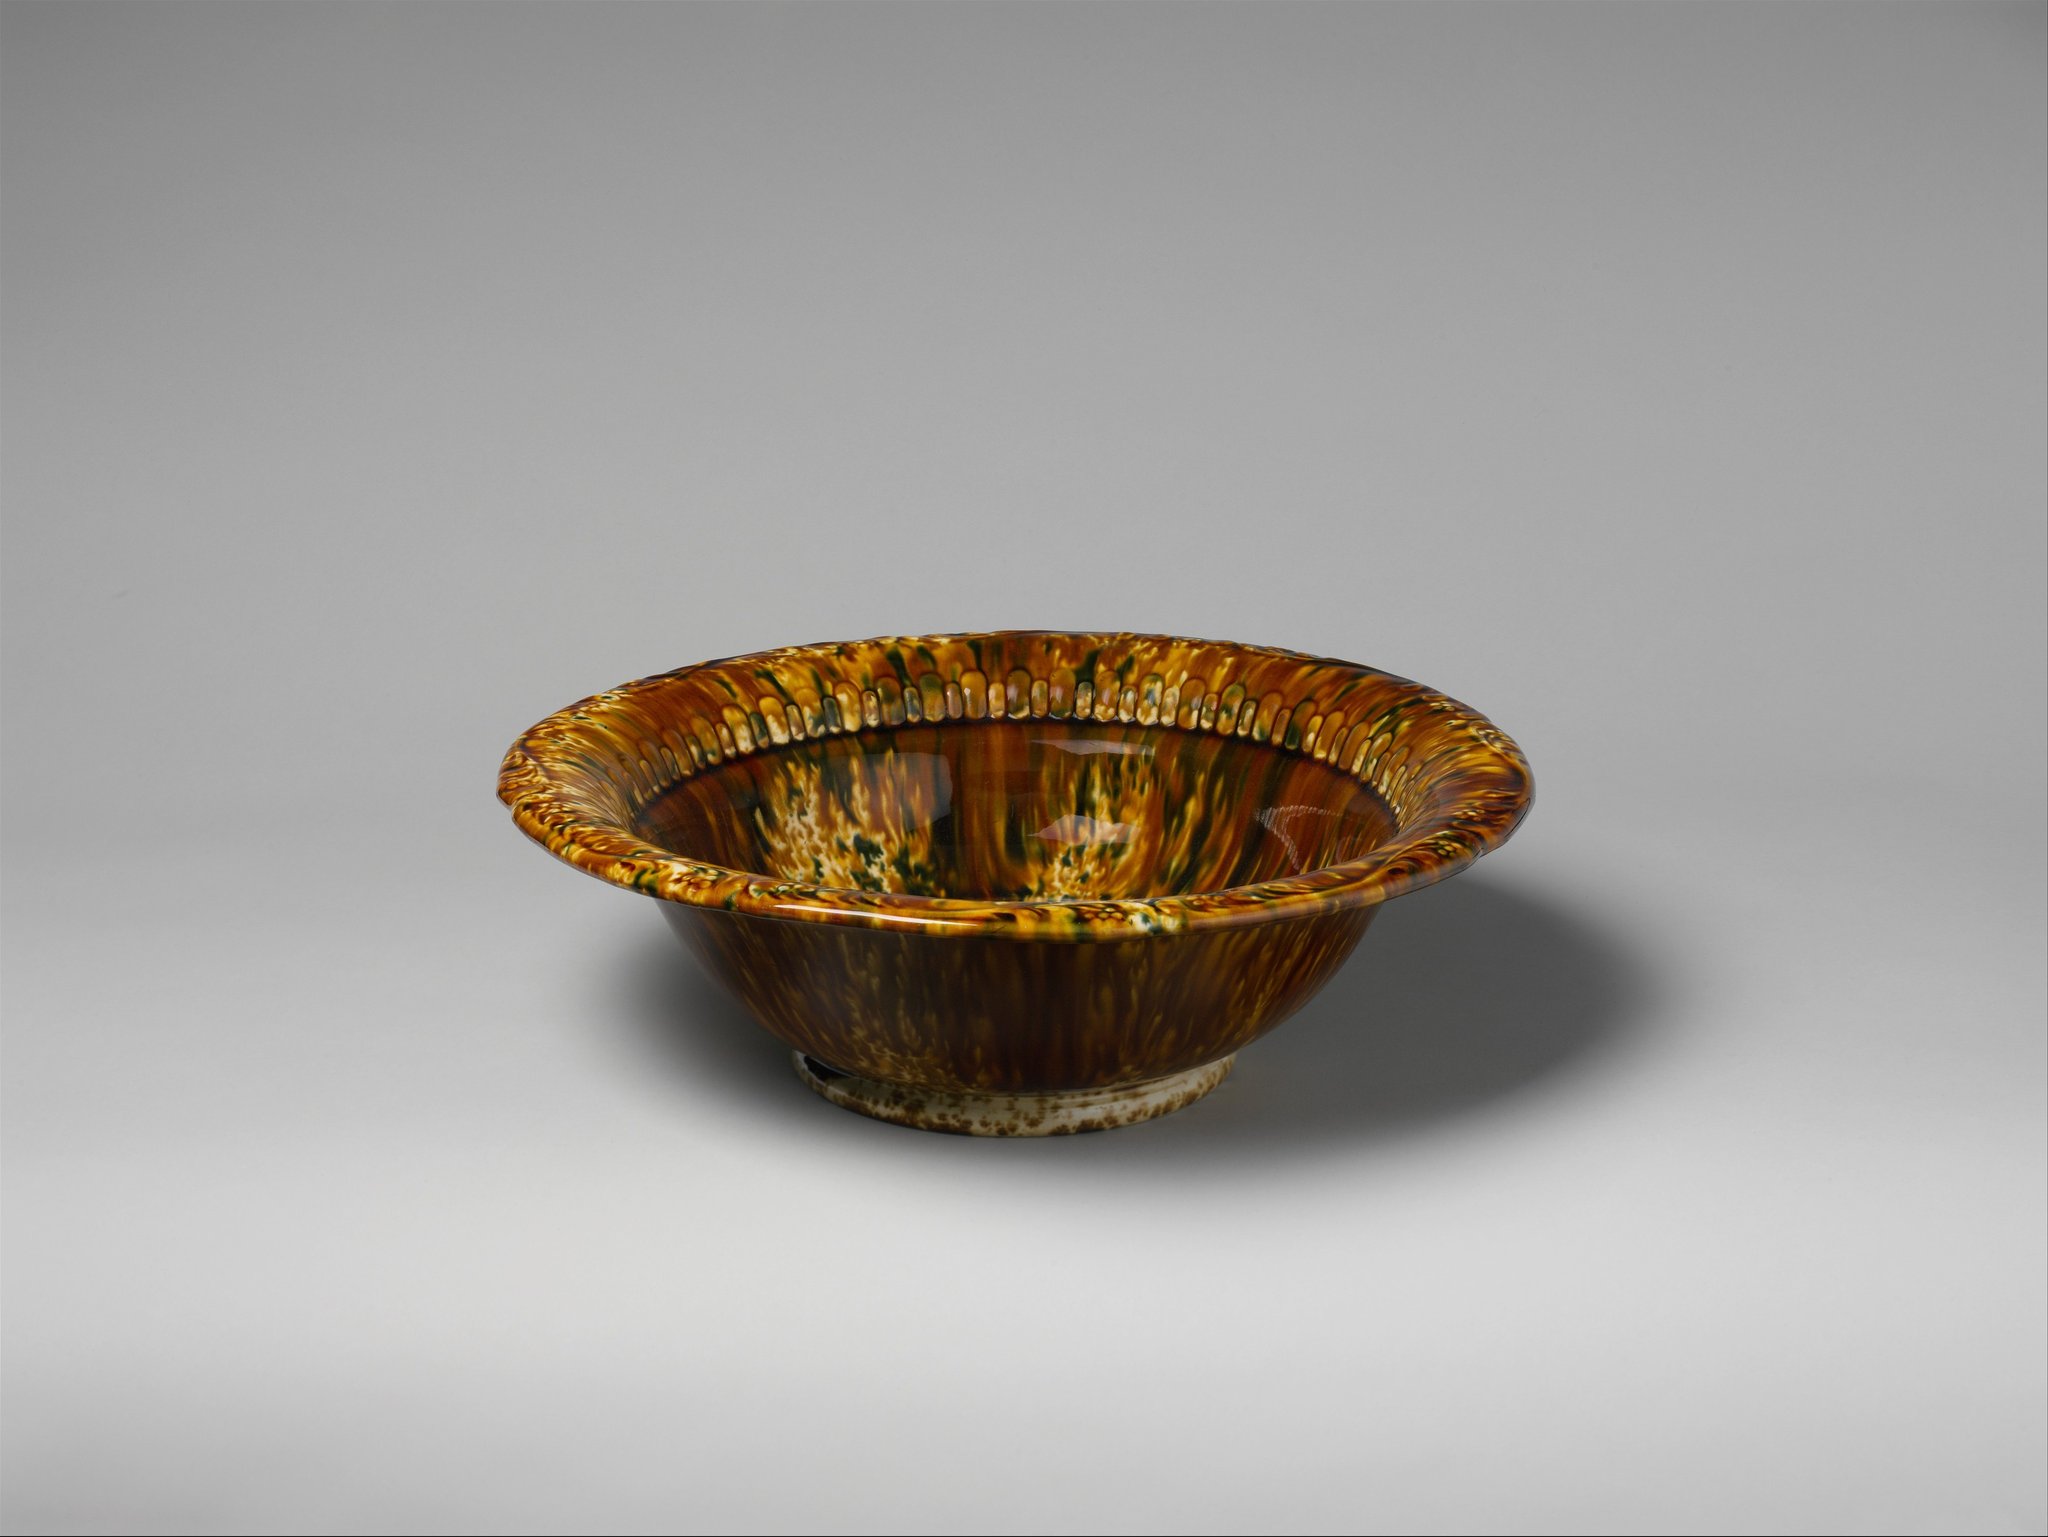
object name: basin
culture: american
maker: united states pottery company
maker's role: maker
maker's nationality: american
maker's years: 1852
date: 1849-1858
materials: earthenware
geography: united states